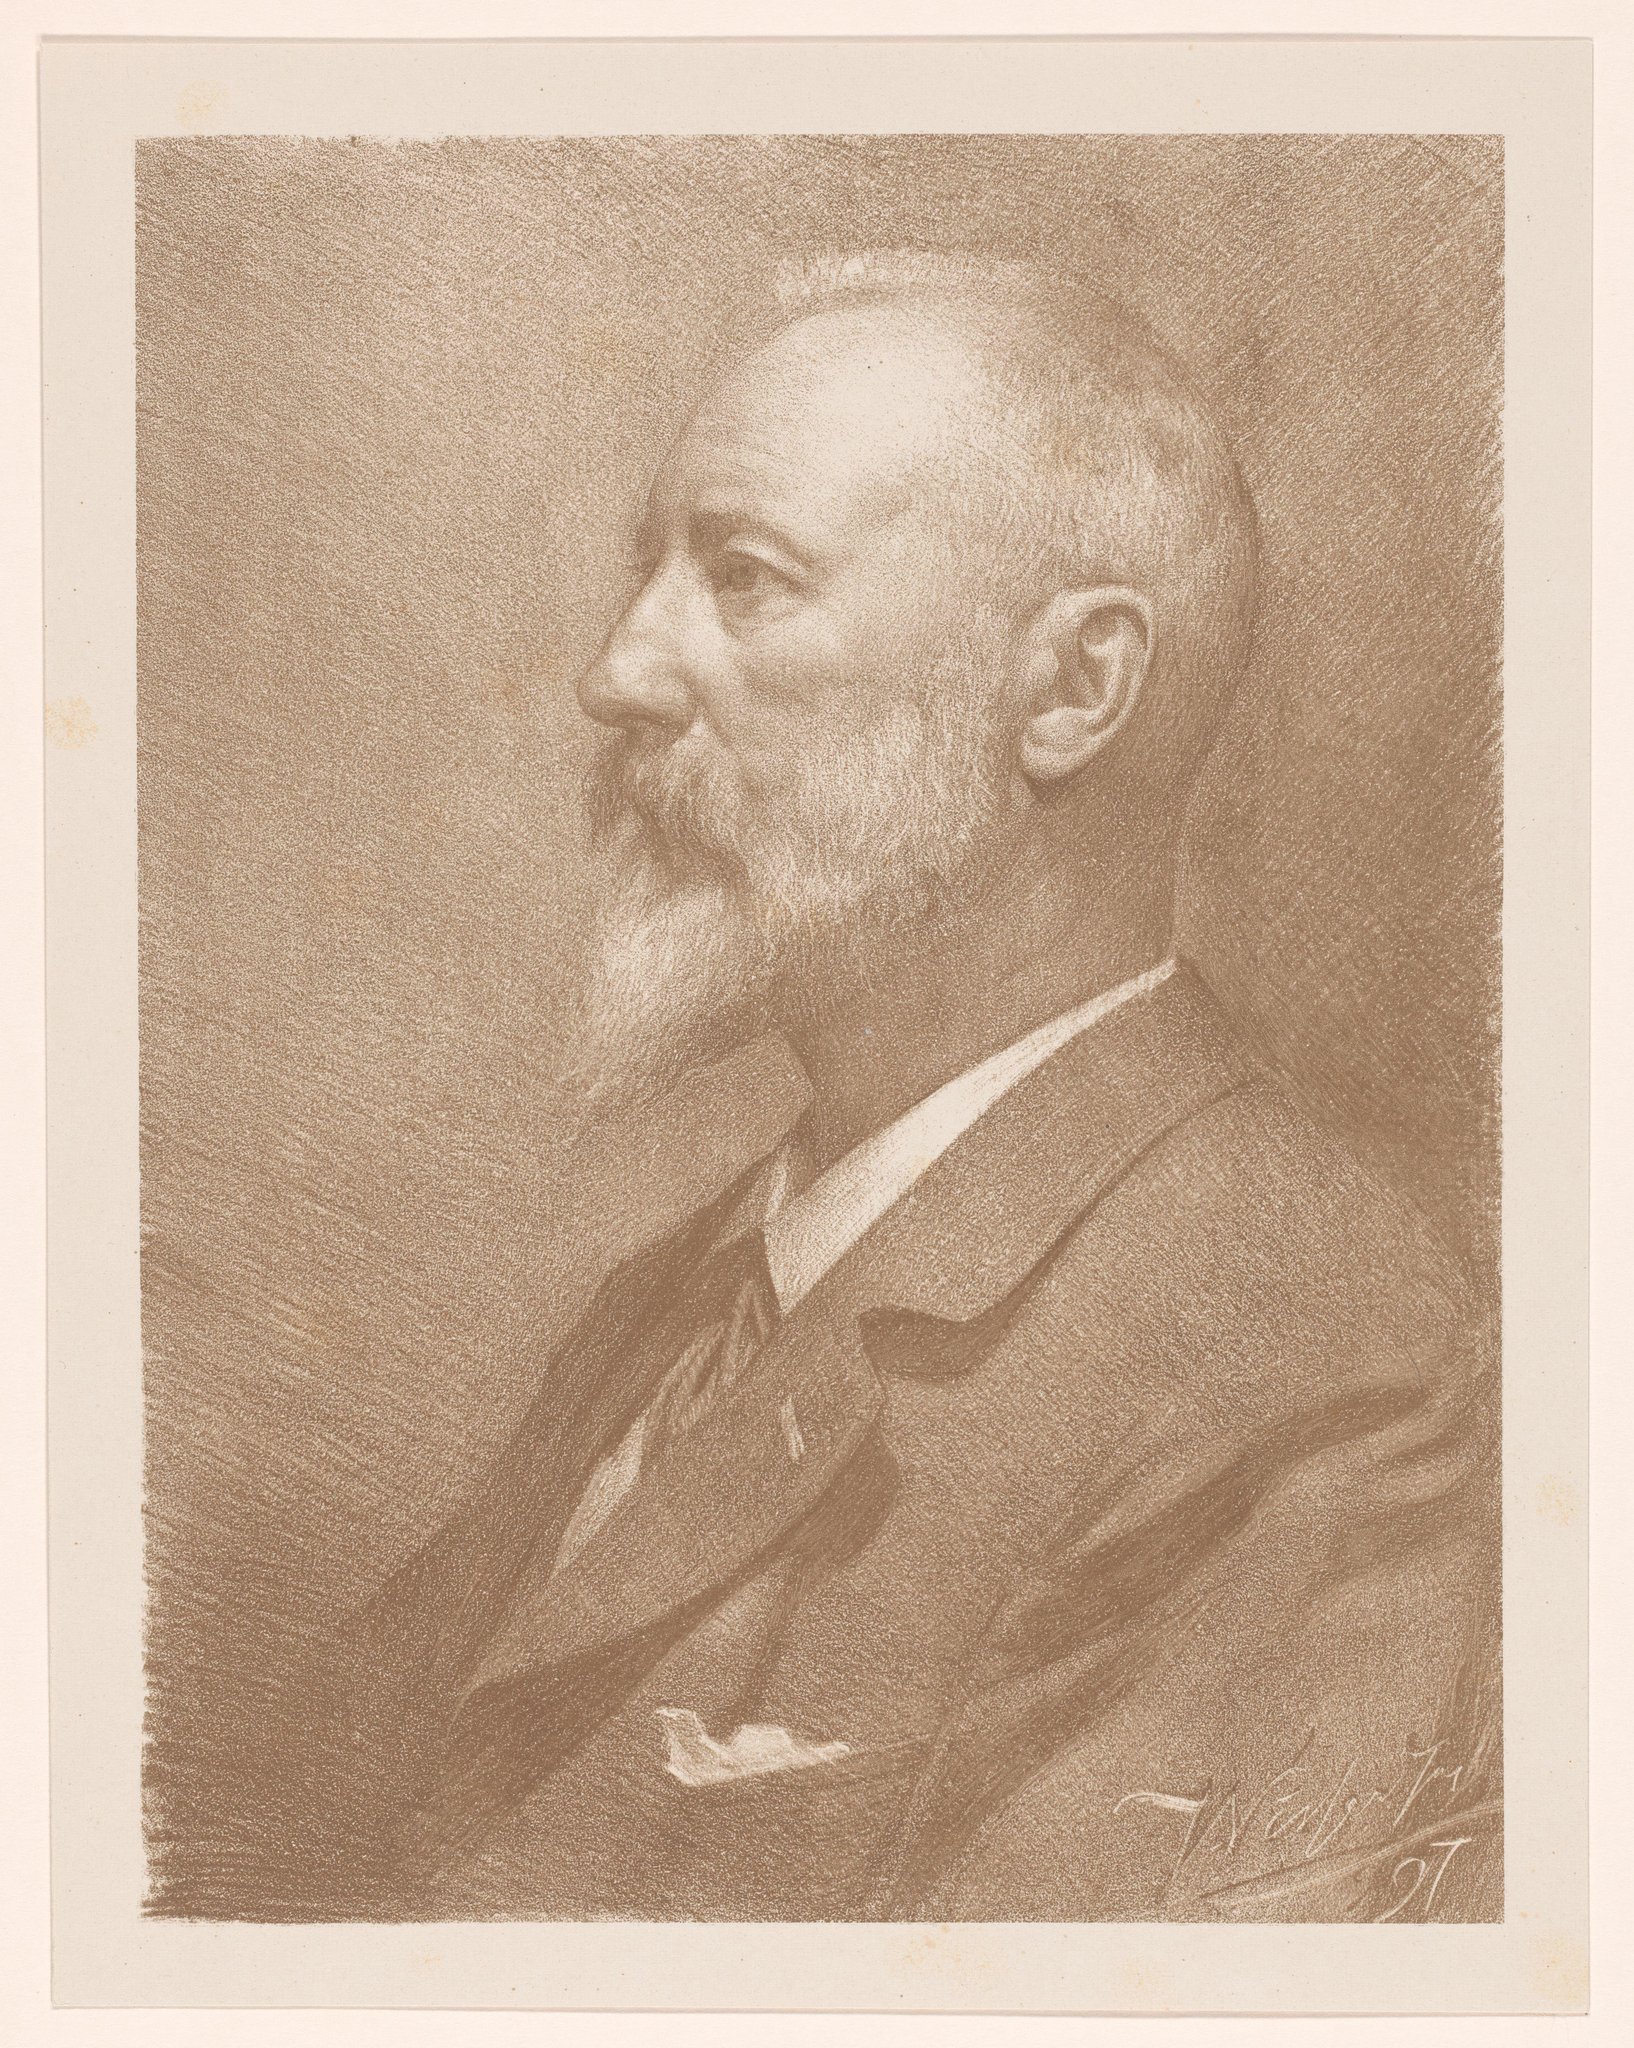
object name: print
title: Portret van beeldhouwer Bart van Hove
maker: jan visser (1856-1938)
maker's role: print maker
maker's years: 1856-1938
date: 1897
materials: paper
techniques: lithograph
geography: netherlands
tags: the hague, amsterdam, sculptor, bart van hove, portrait, self-portrait of sculptor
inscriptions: collector's mark: Lugt 2228